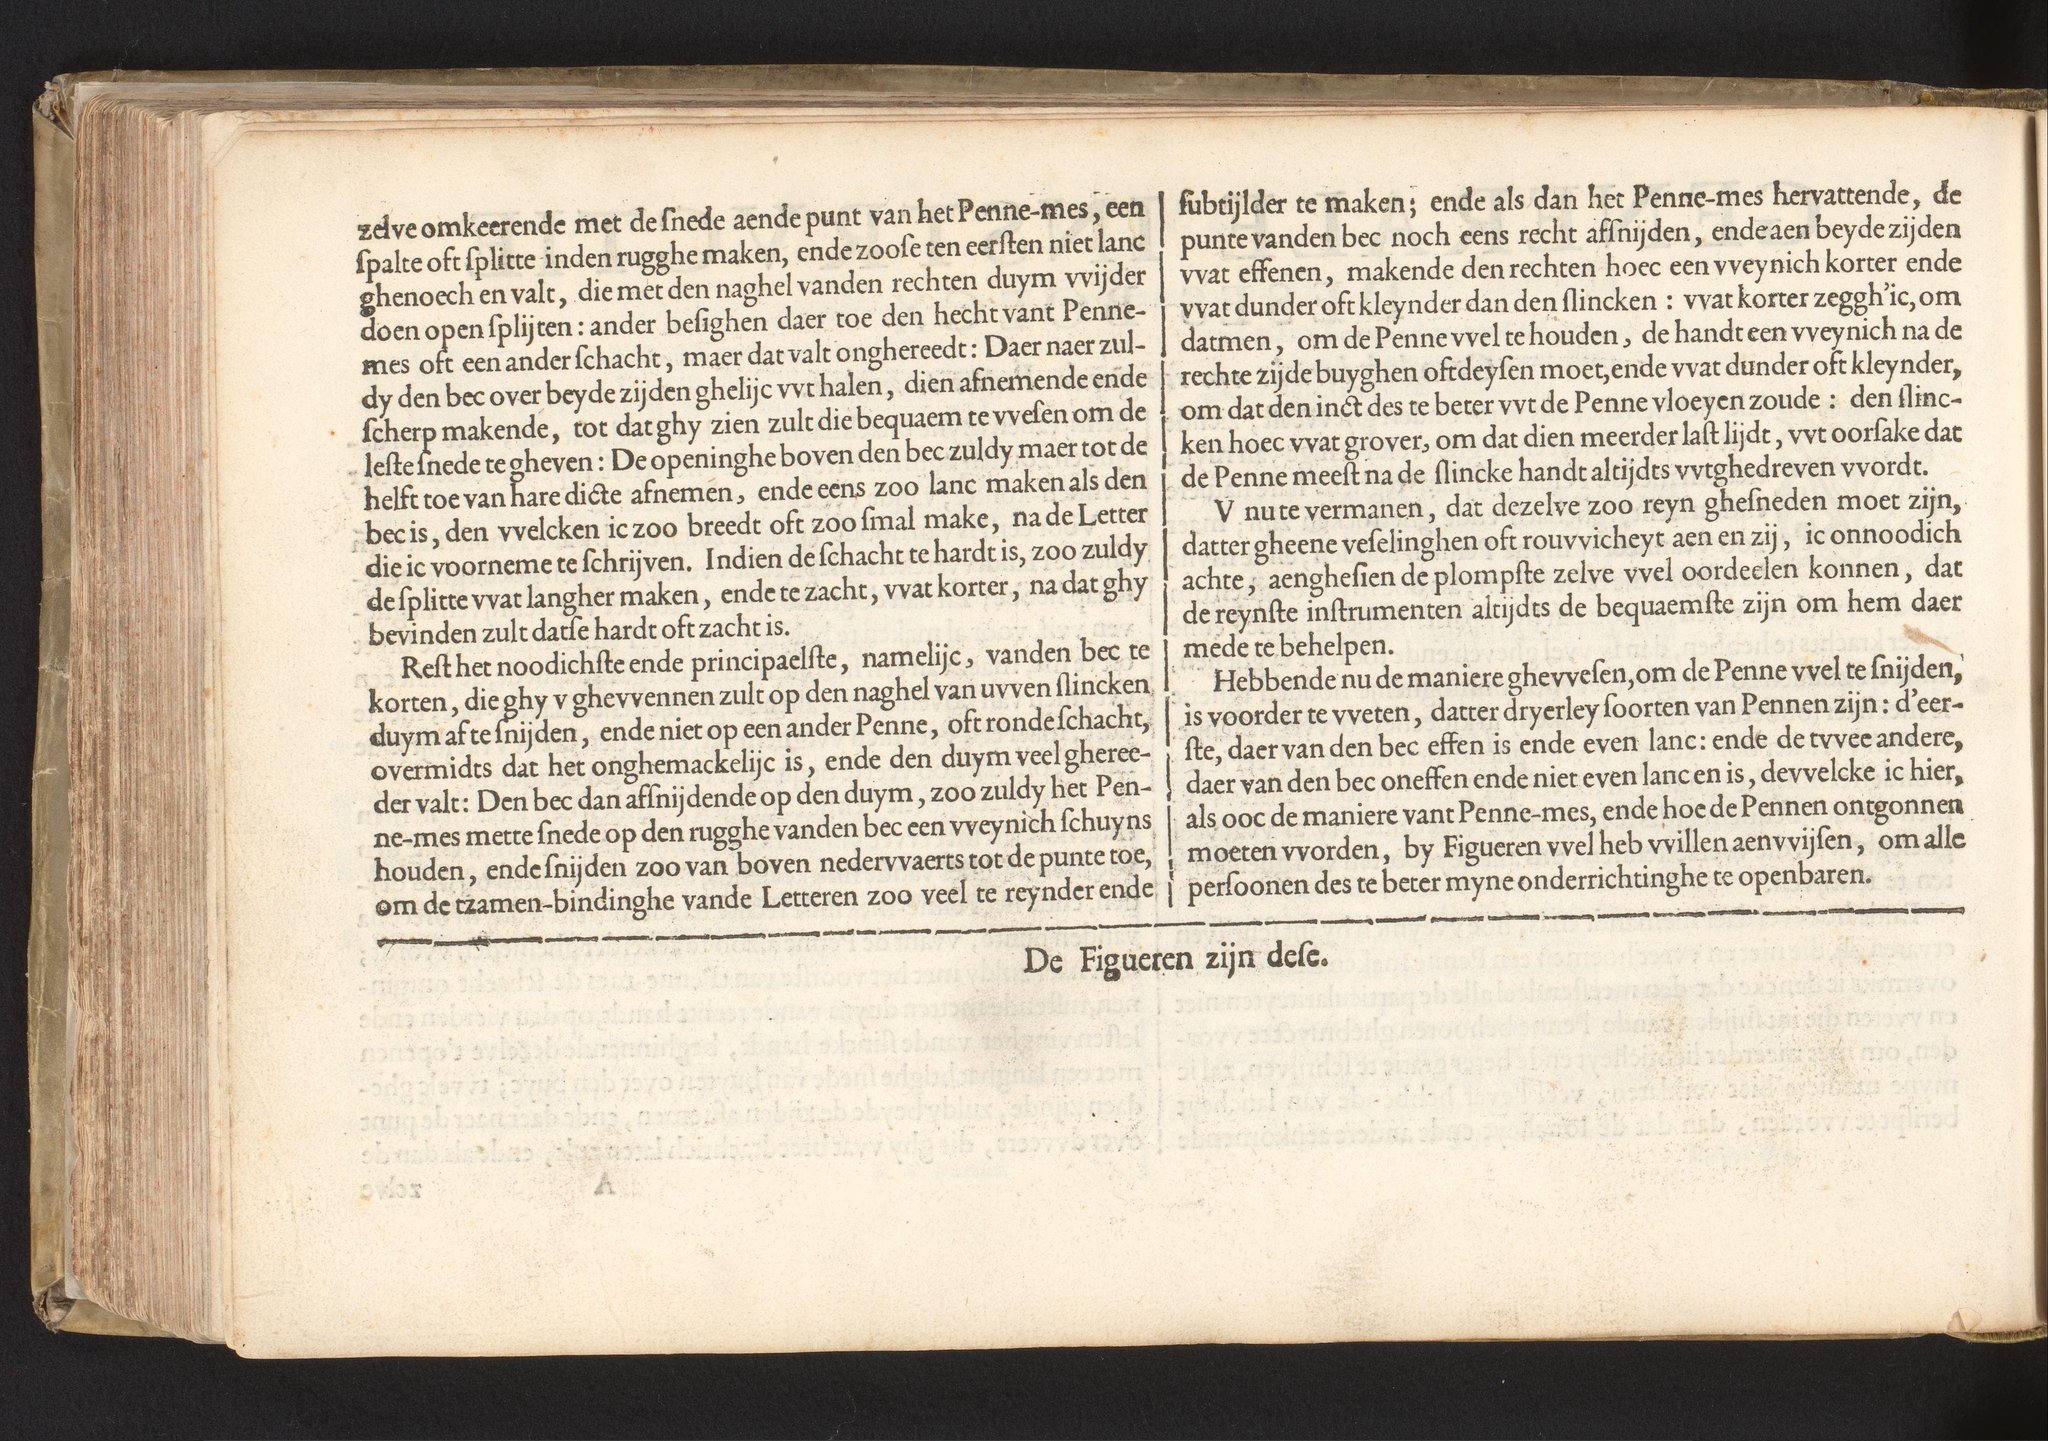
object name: album leaf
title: Spieghel der schrijfkonste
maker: jan van de velde (i)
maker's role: painter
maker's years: 1568-1623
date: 1605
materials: paper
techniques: letterpress printing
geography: rotterdam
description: Tekstblad met een instructie hoe je een goede rietpen maakt, pagina 2 van 2. Het tekstblad maakt deel uit van een album.